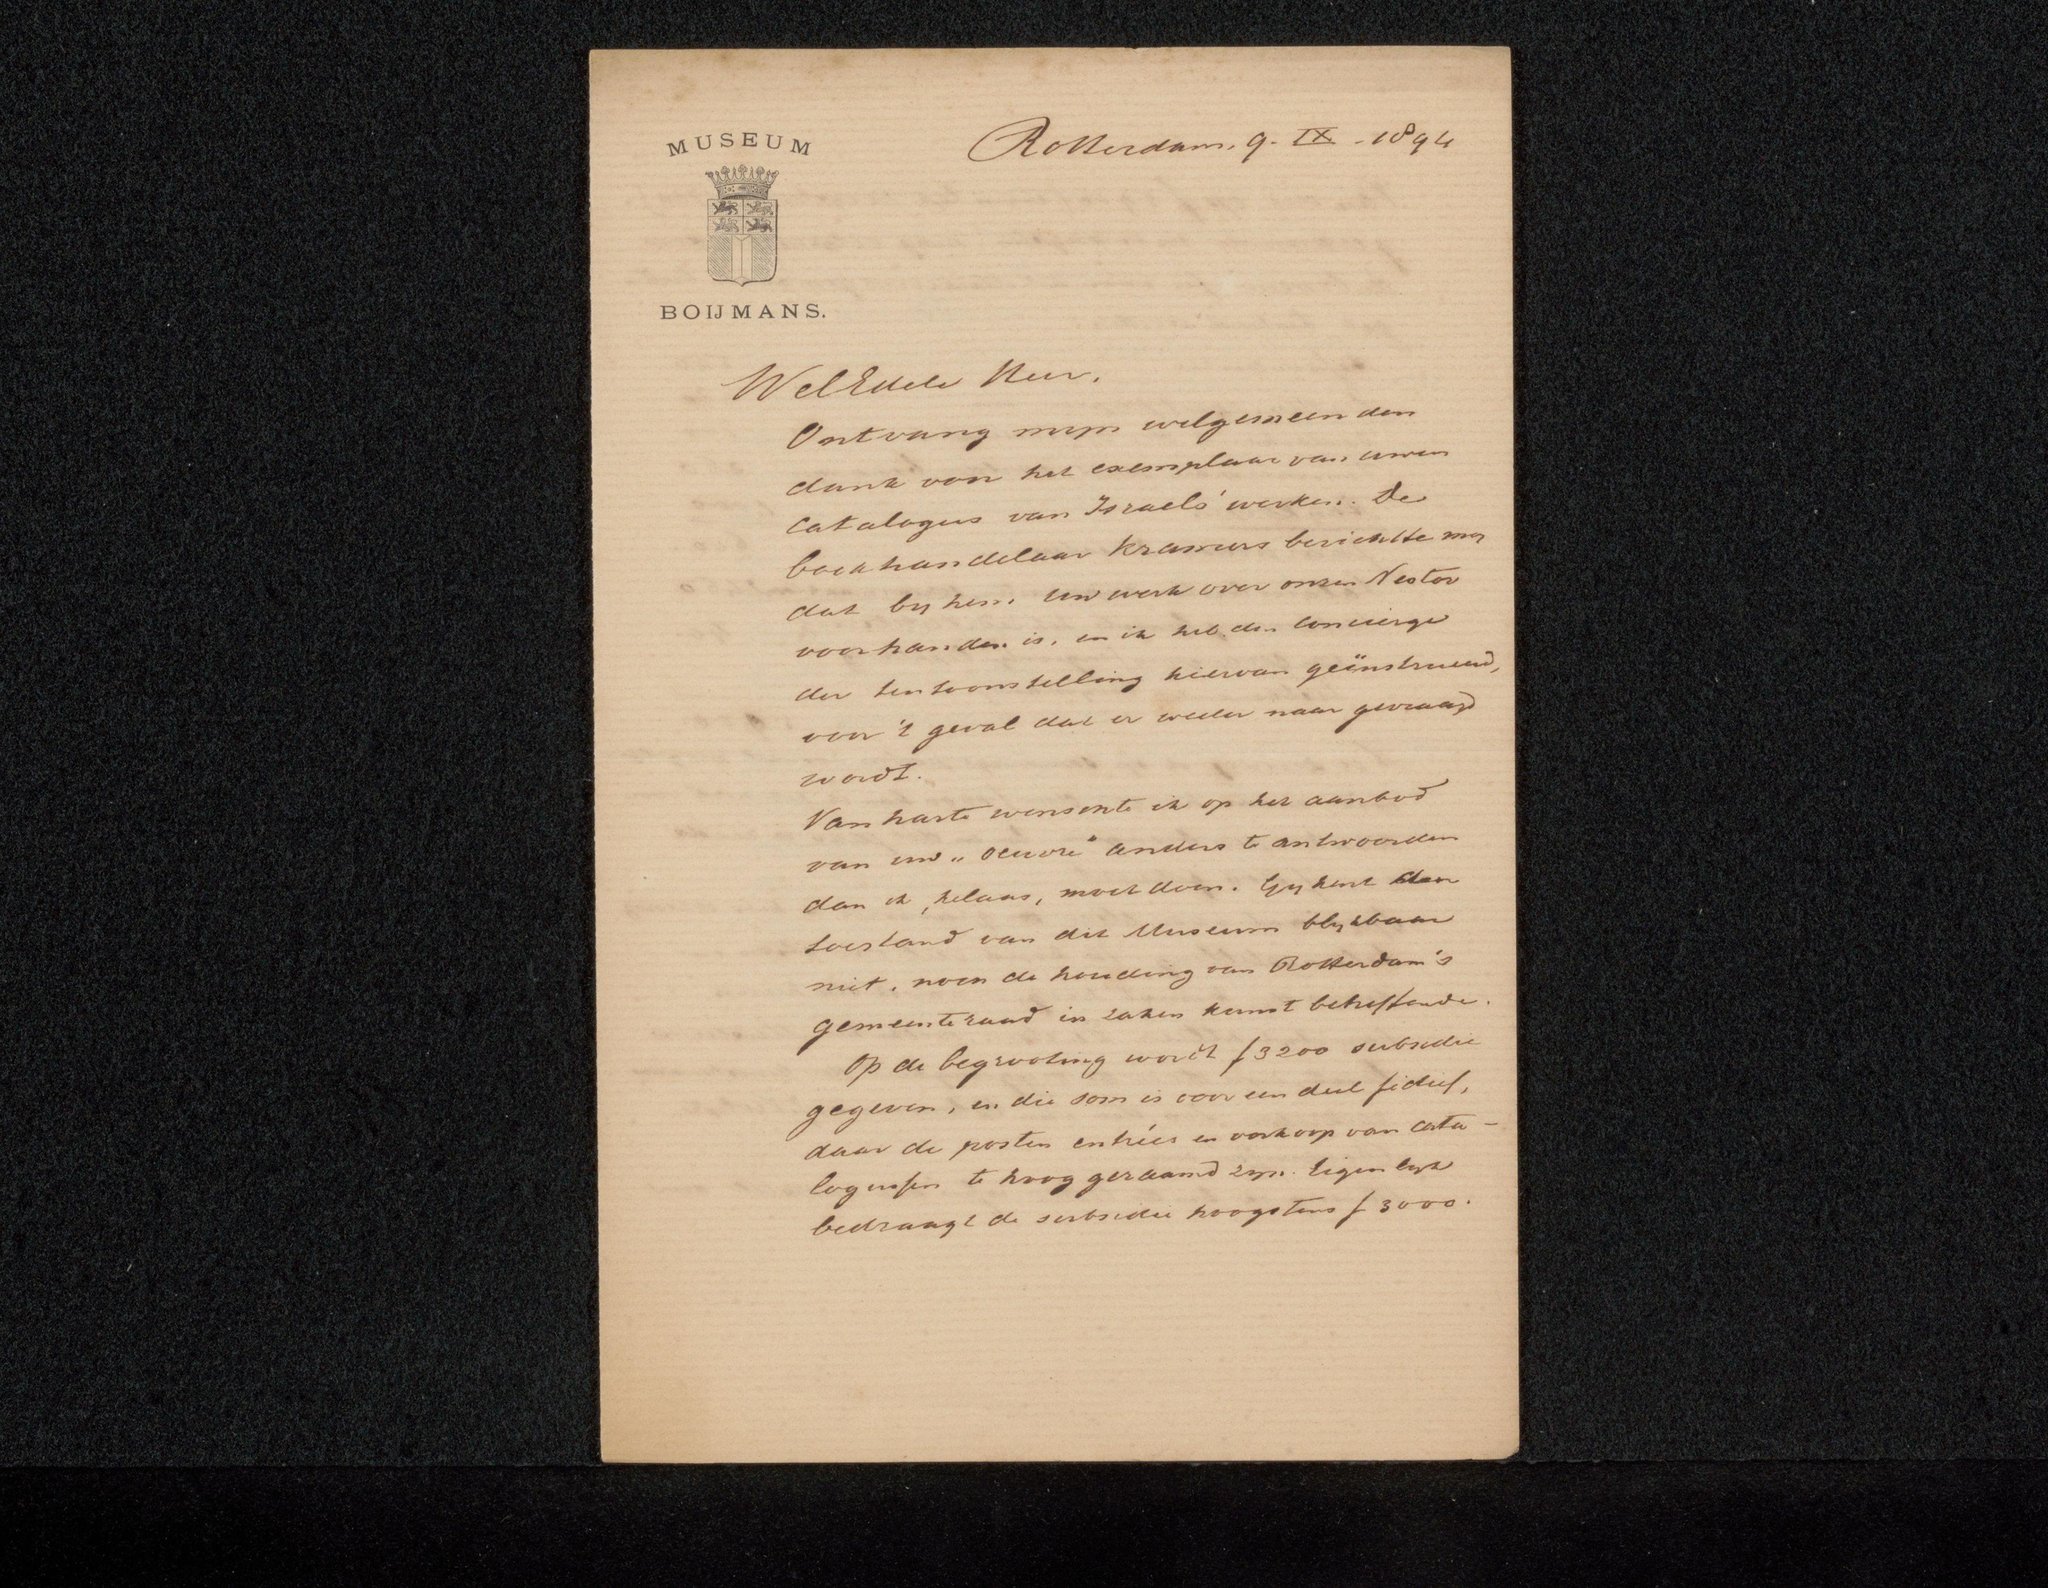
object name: letter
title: Brief aan Philip Zilcken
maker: pieter haverkorn van rijsewijk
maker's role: museumdirecteur, publicist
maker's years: 1839-1919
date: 1894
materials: ink, paper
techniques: pen, printing, writing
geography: rotterdam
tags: amsterdam, petrus johannes arendzen, rotterdam, charles rochussen, jozef israëls, print maker, draughtsman, bernardus johannes blommers, painter, jacoba van heemskerck, philip zilcken, the graphic arts, painting (including book-illumination, miniature-painting), exhibition ~ art, money, printed matter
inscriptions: collector's mark: ‘RPK’